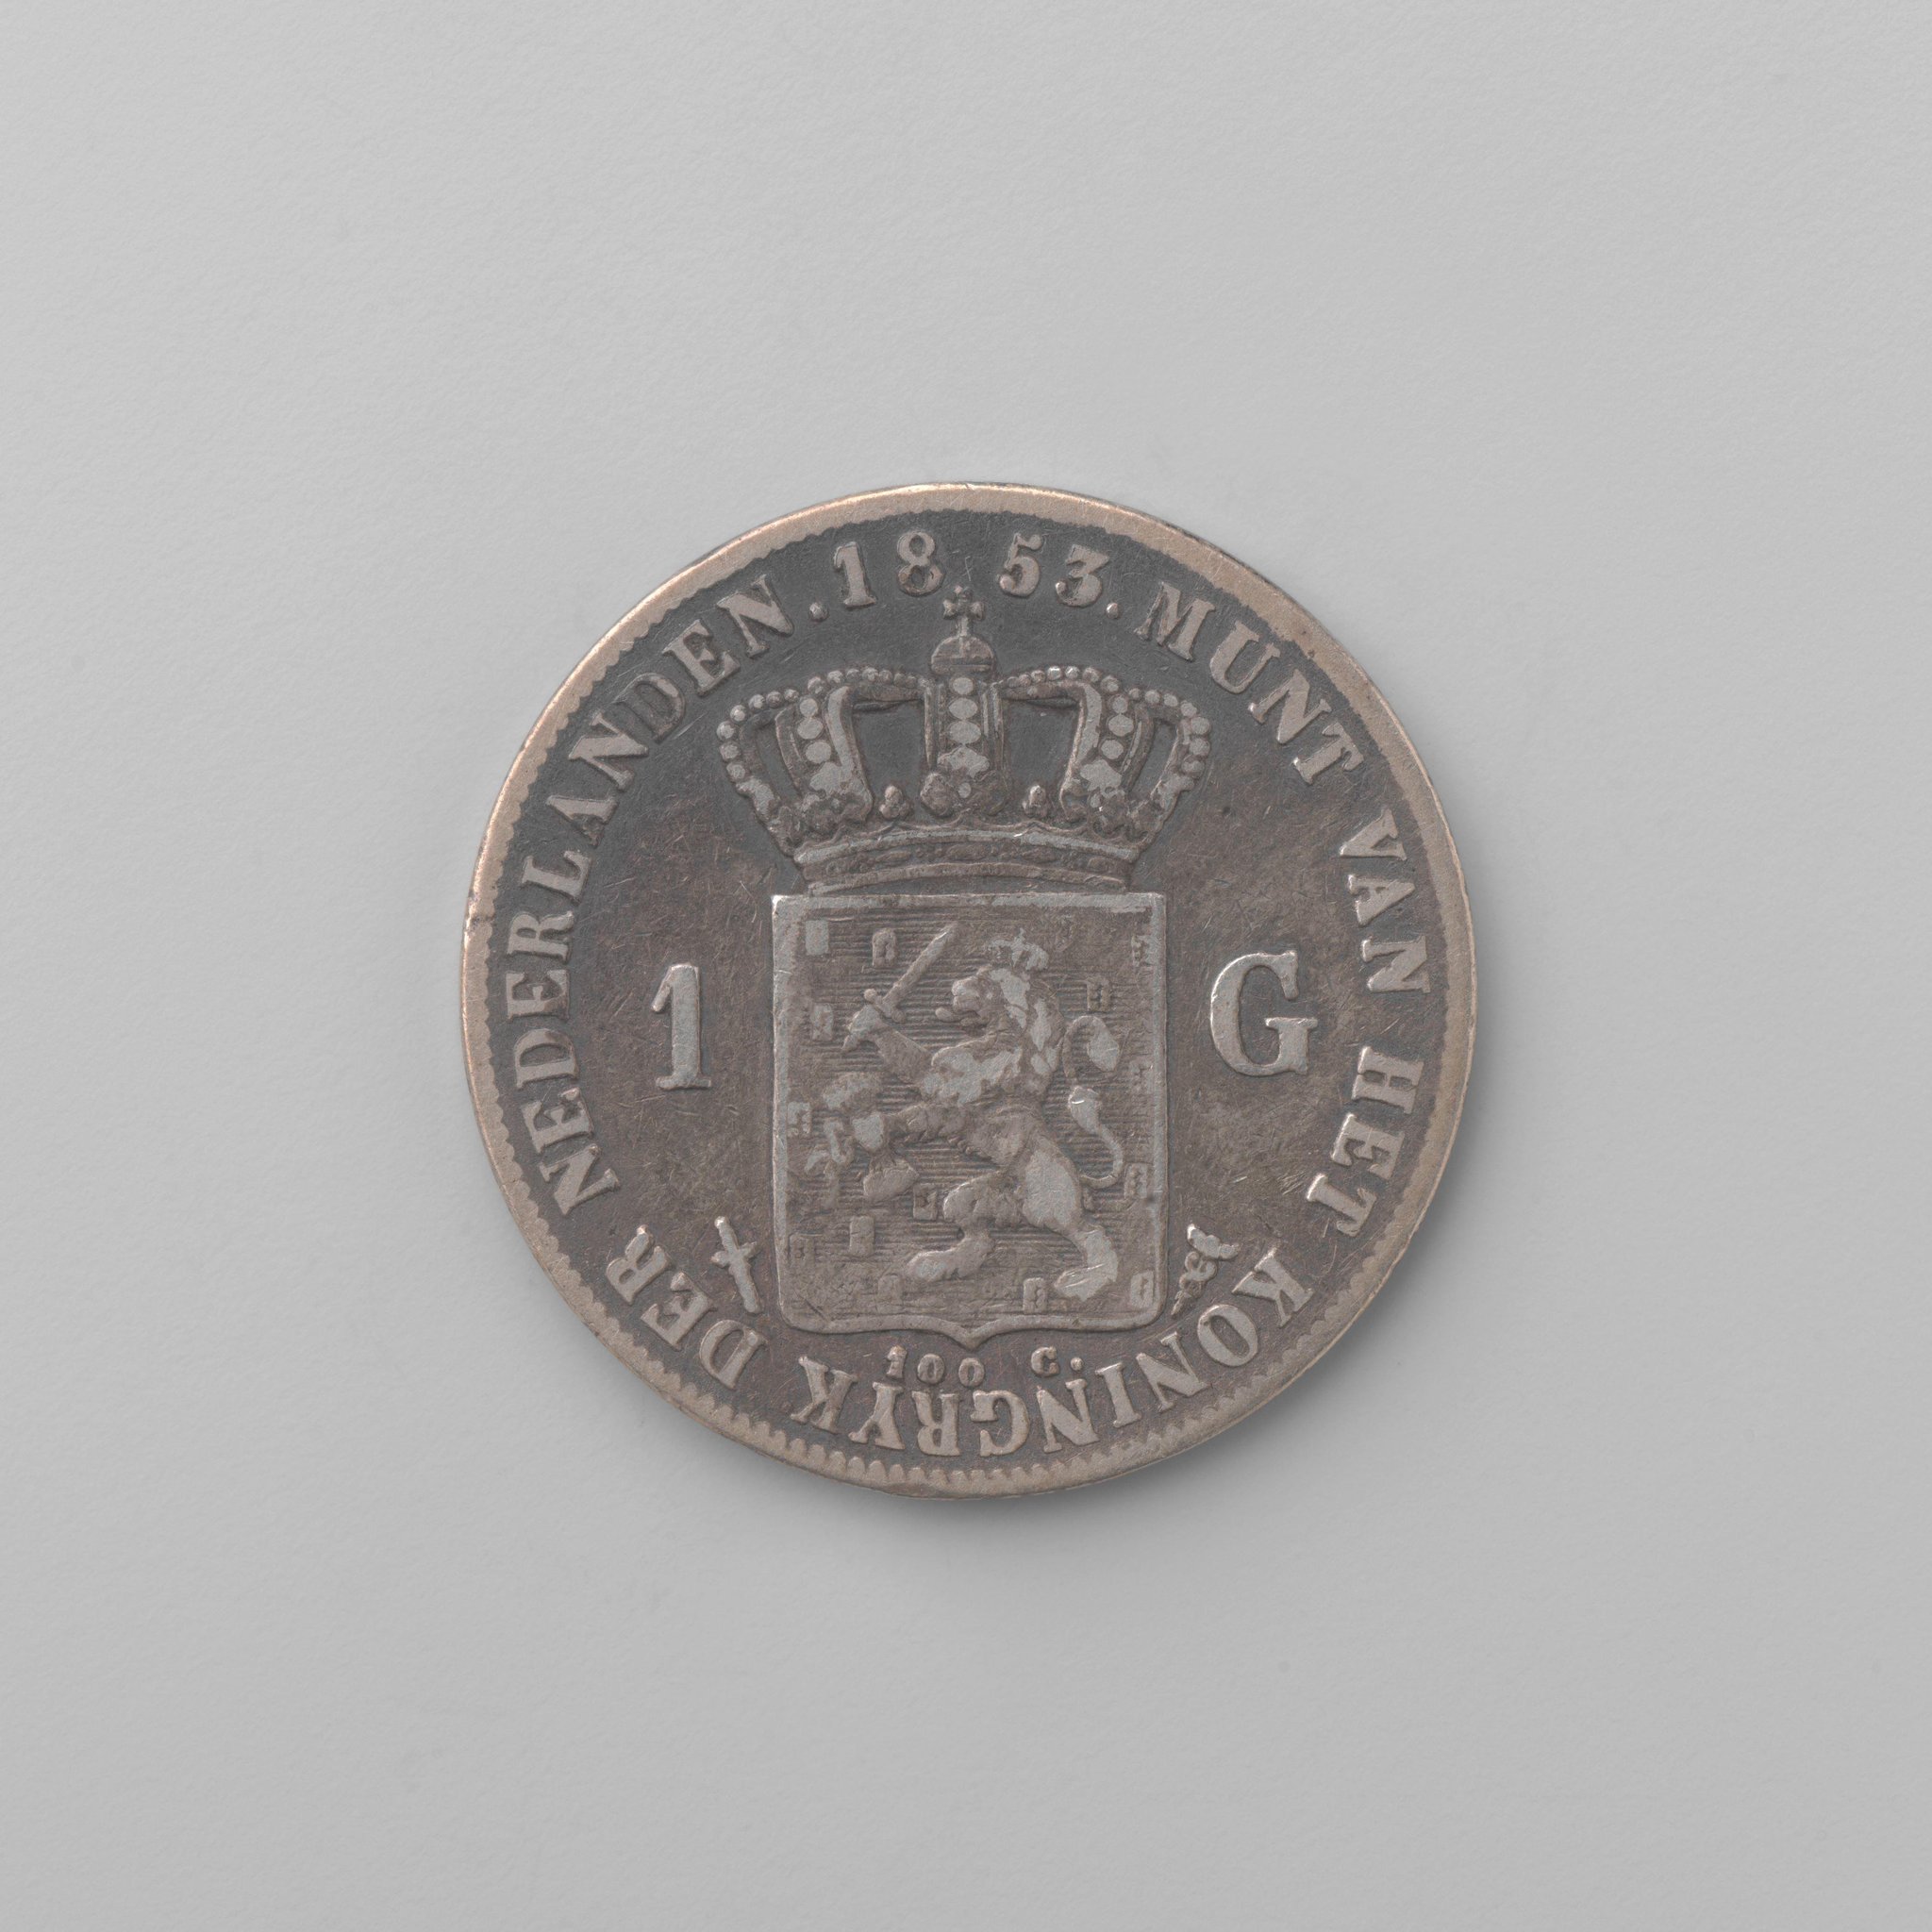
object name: coin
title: Nederlandse gulden, 1853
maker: willem iii (koning der nederlanden)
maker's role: koning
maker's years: 1817-1890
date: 1853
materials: silver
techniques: striking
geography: utrecht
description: Zilveren munt. Voorzijde: borstbeeld naar rechts. Keerzijde: tussen waarde-aanduiding 1 G gekroond rijkswapenschild. Jaartal boven kroon. Randschrift.